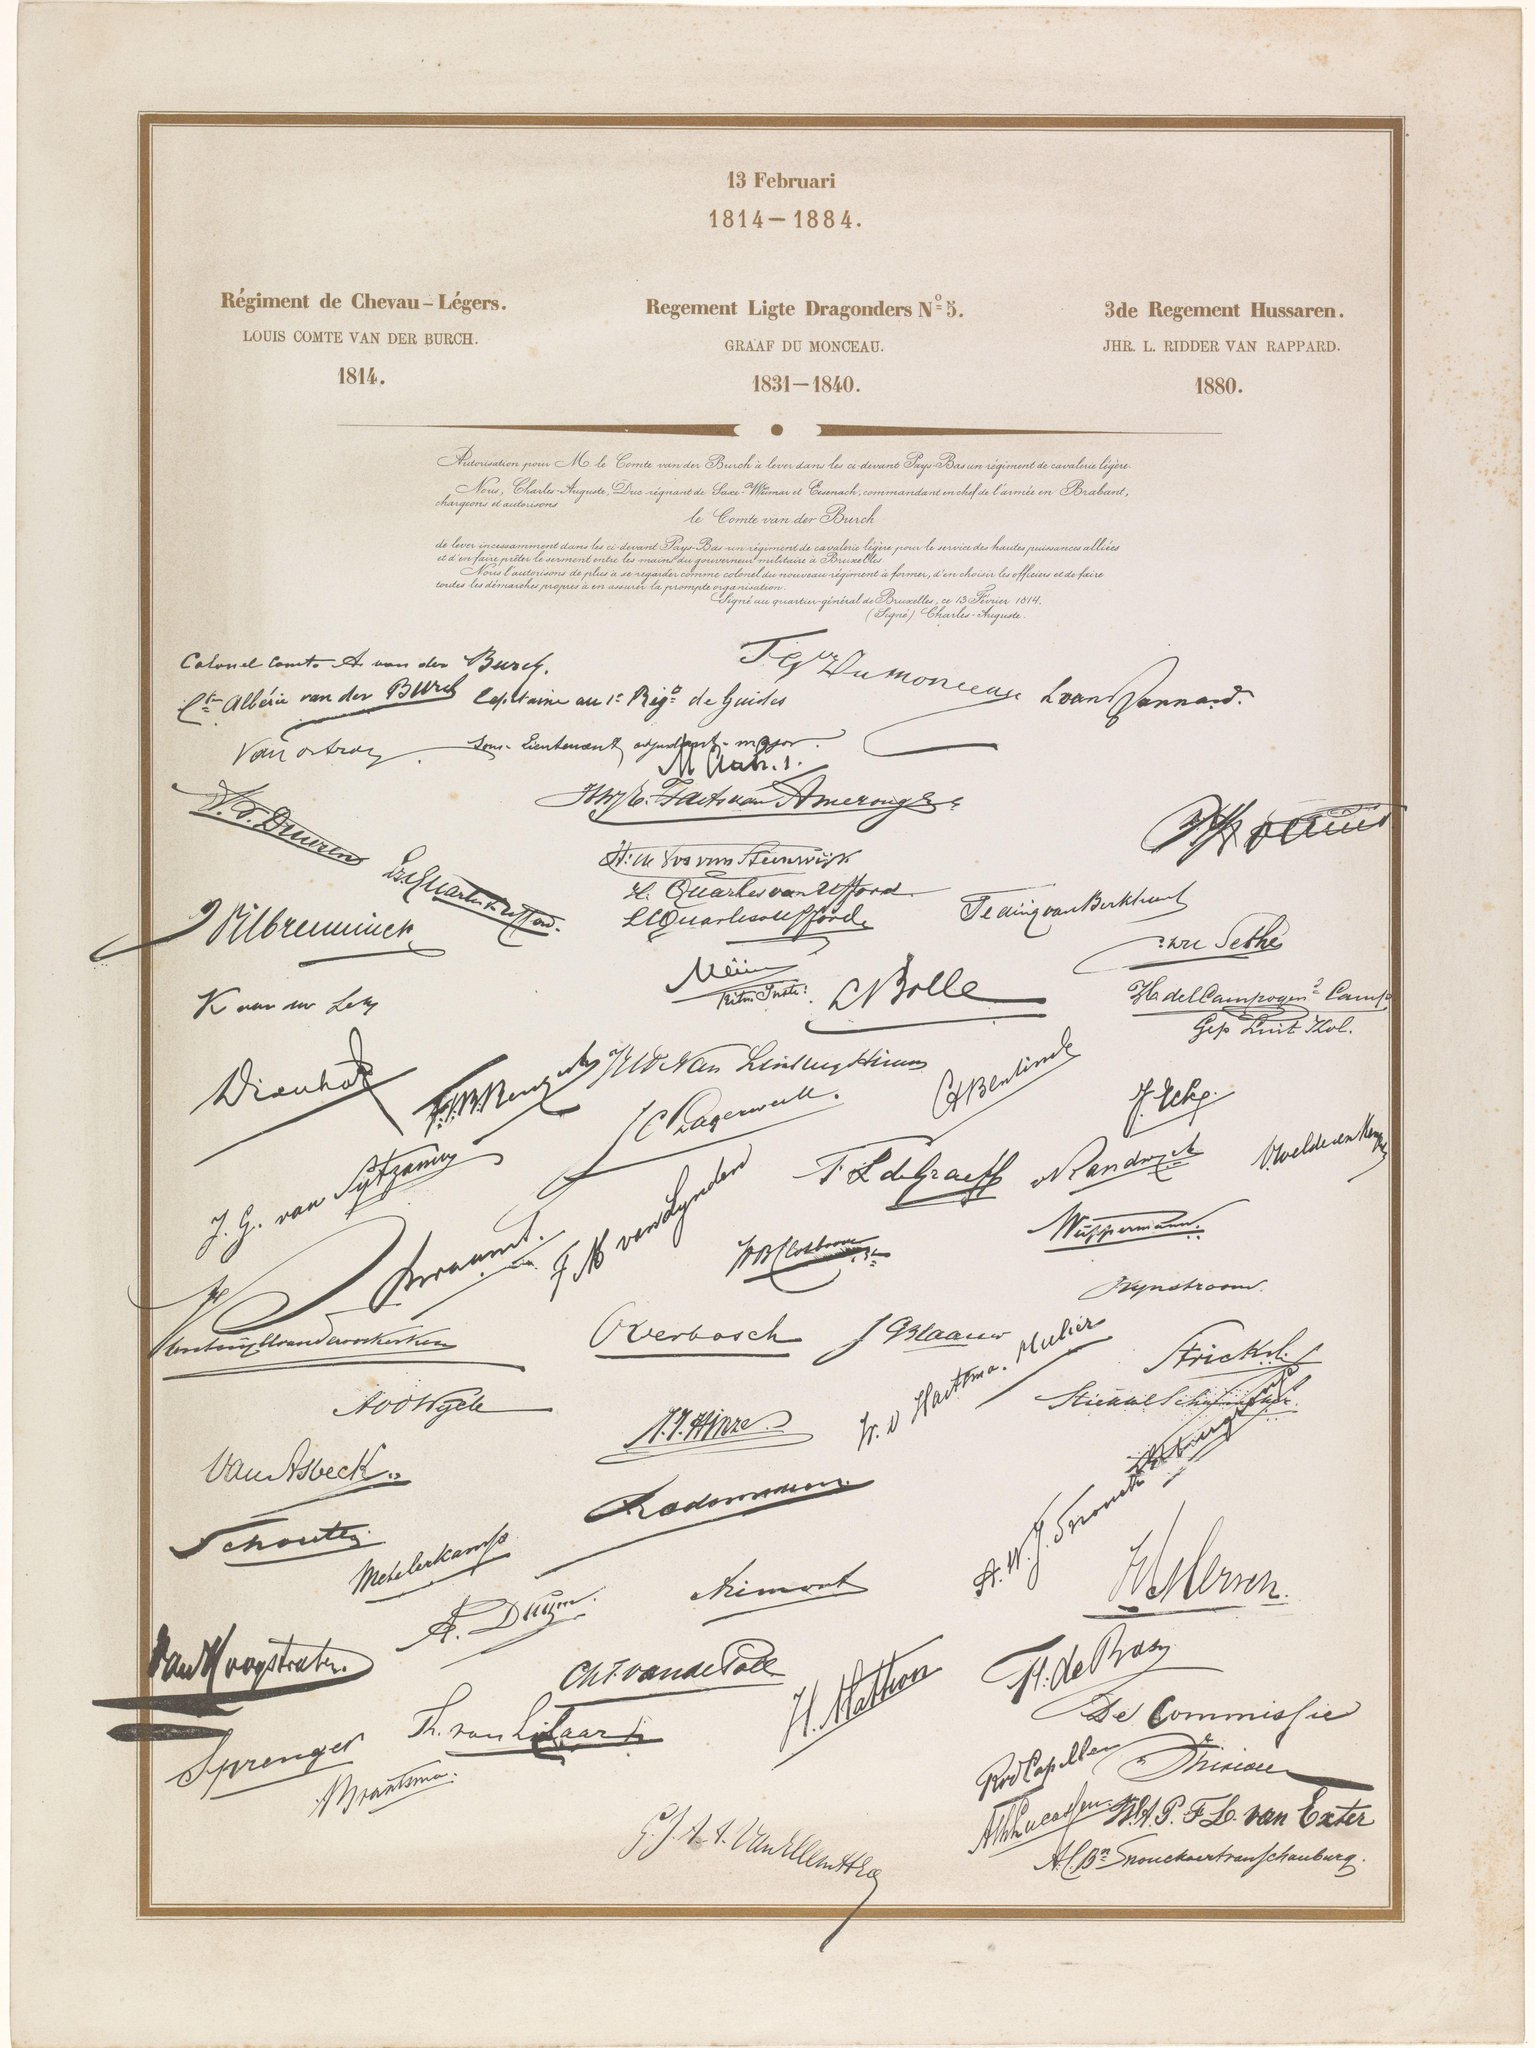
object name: print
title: 13 Februarij 1814-1884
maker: Anonymous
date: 1884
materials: paper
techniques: printing, lithograph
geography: netherlands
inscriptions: collector's mark: Lugt 2228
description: Handtekeningen van de aanwezigen. Gerelateerd aan het blad met een overzicht van de verschillende uniformen gedragen door de commandanten het Regiment Dragonders in de periode 1814-1884. Waarschijnlijk vervaardigd ter gelegenheid van het 70-jarig bestaan van het Regiment in 1884.